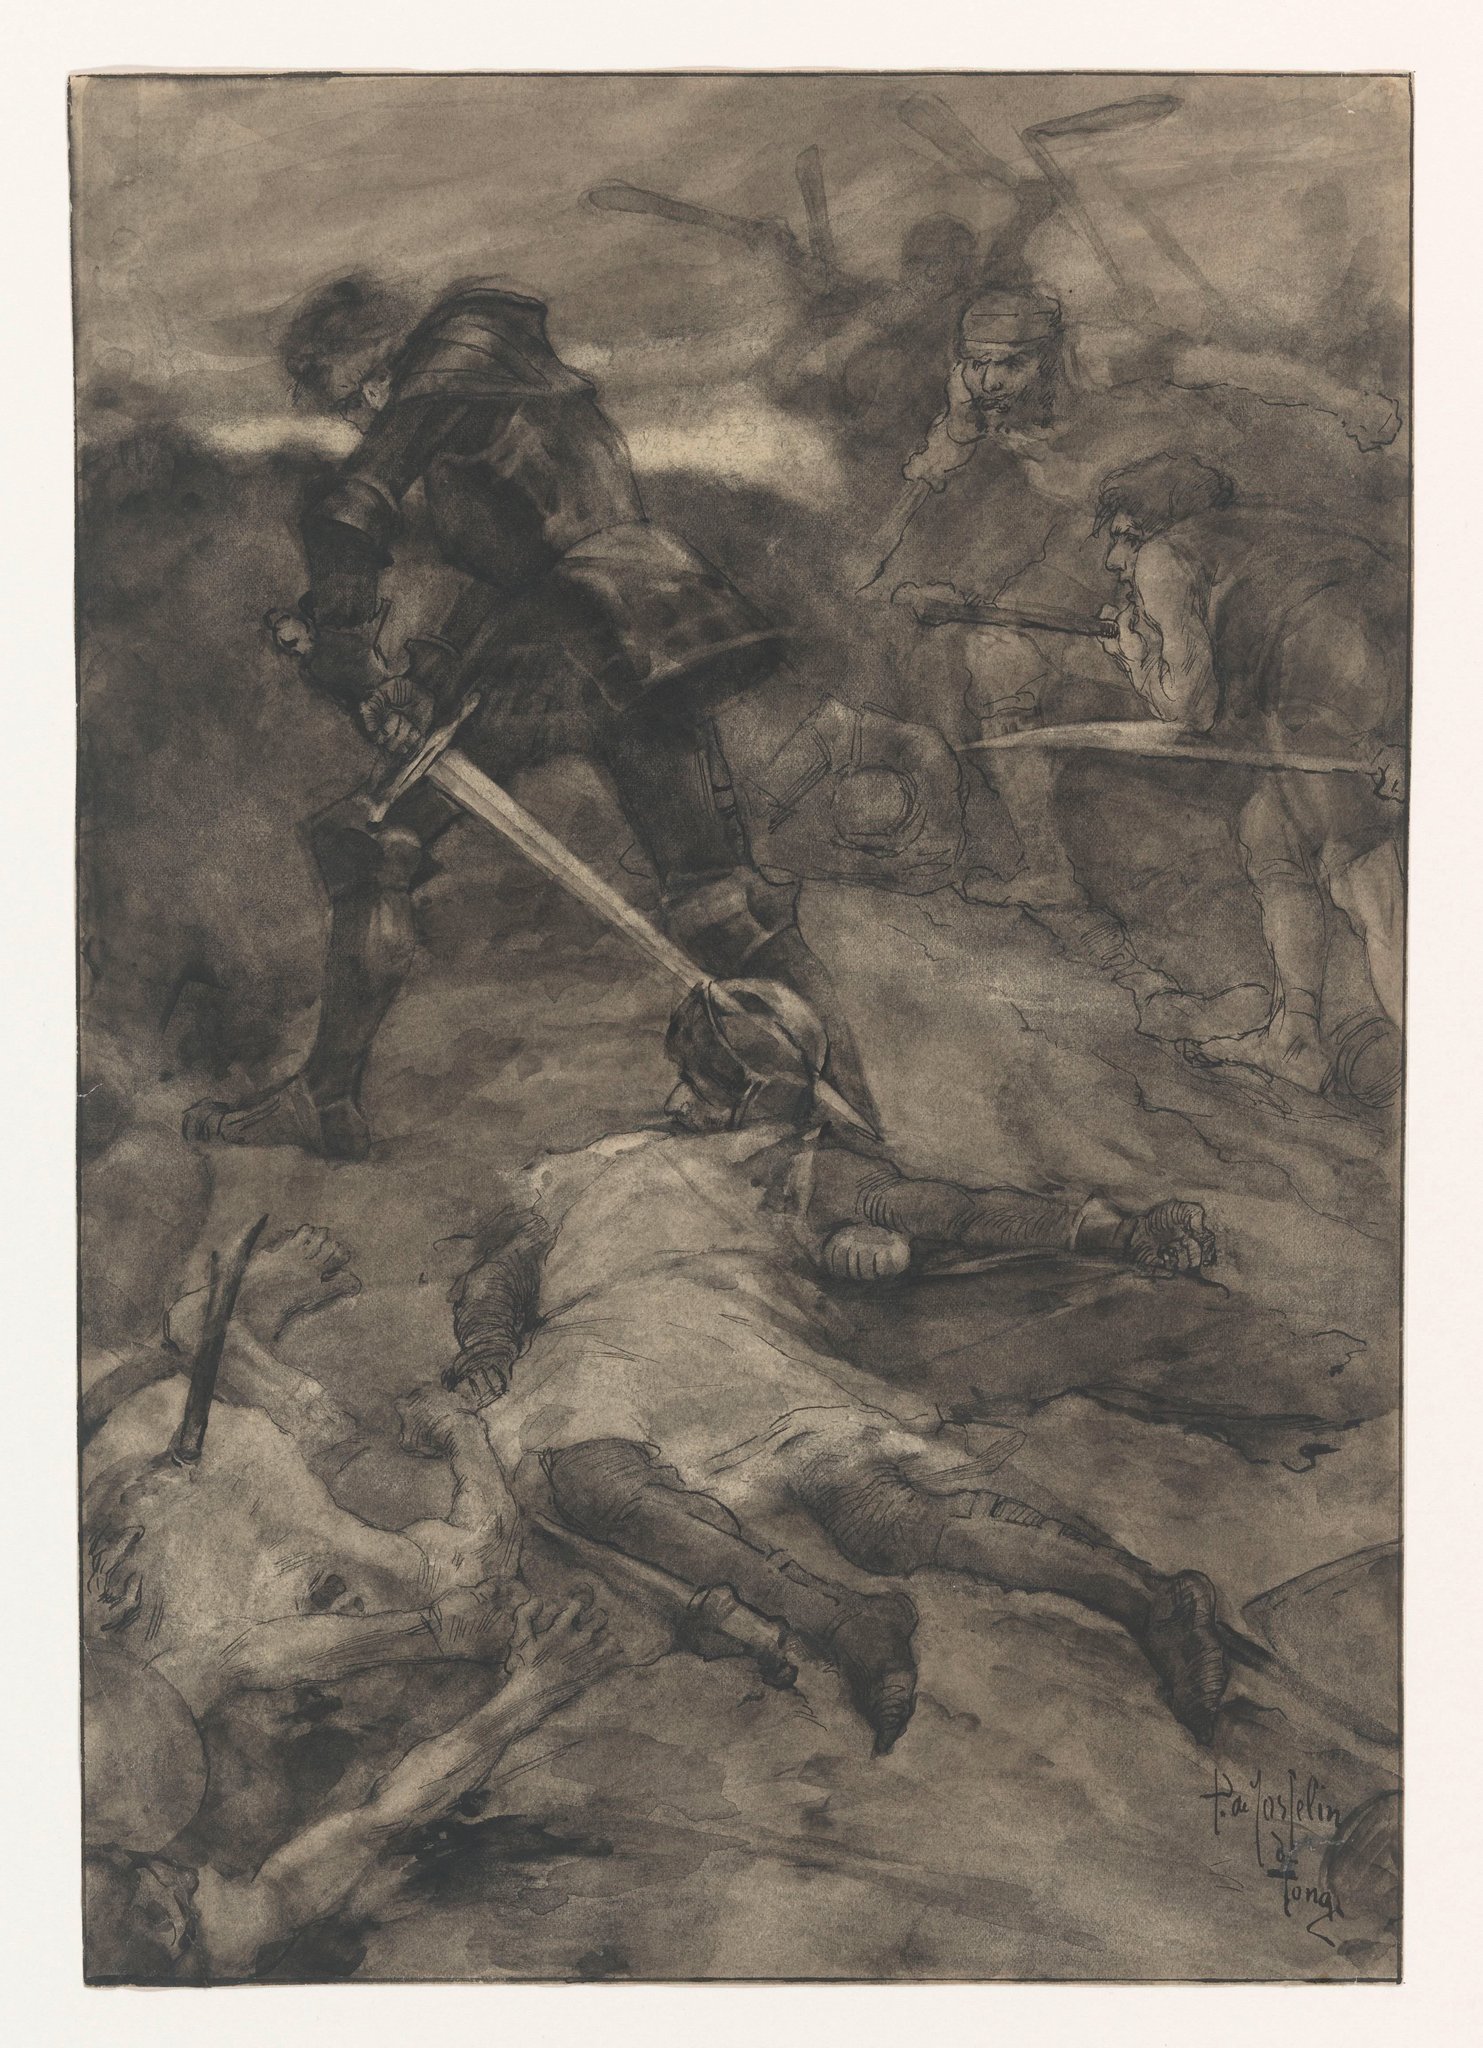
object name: drawing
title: Historische voorstelling van een veldslag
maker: pieter de josselin de jong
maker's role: draughtsman, painter, print maker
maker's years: 1861-1906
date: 1871-1906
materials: chalk, ink, paper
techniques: brush, pen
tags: battle (+ land forces)